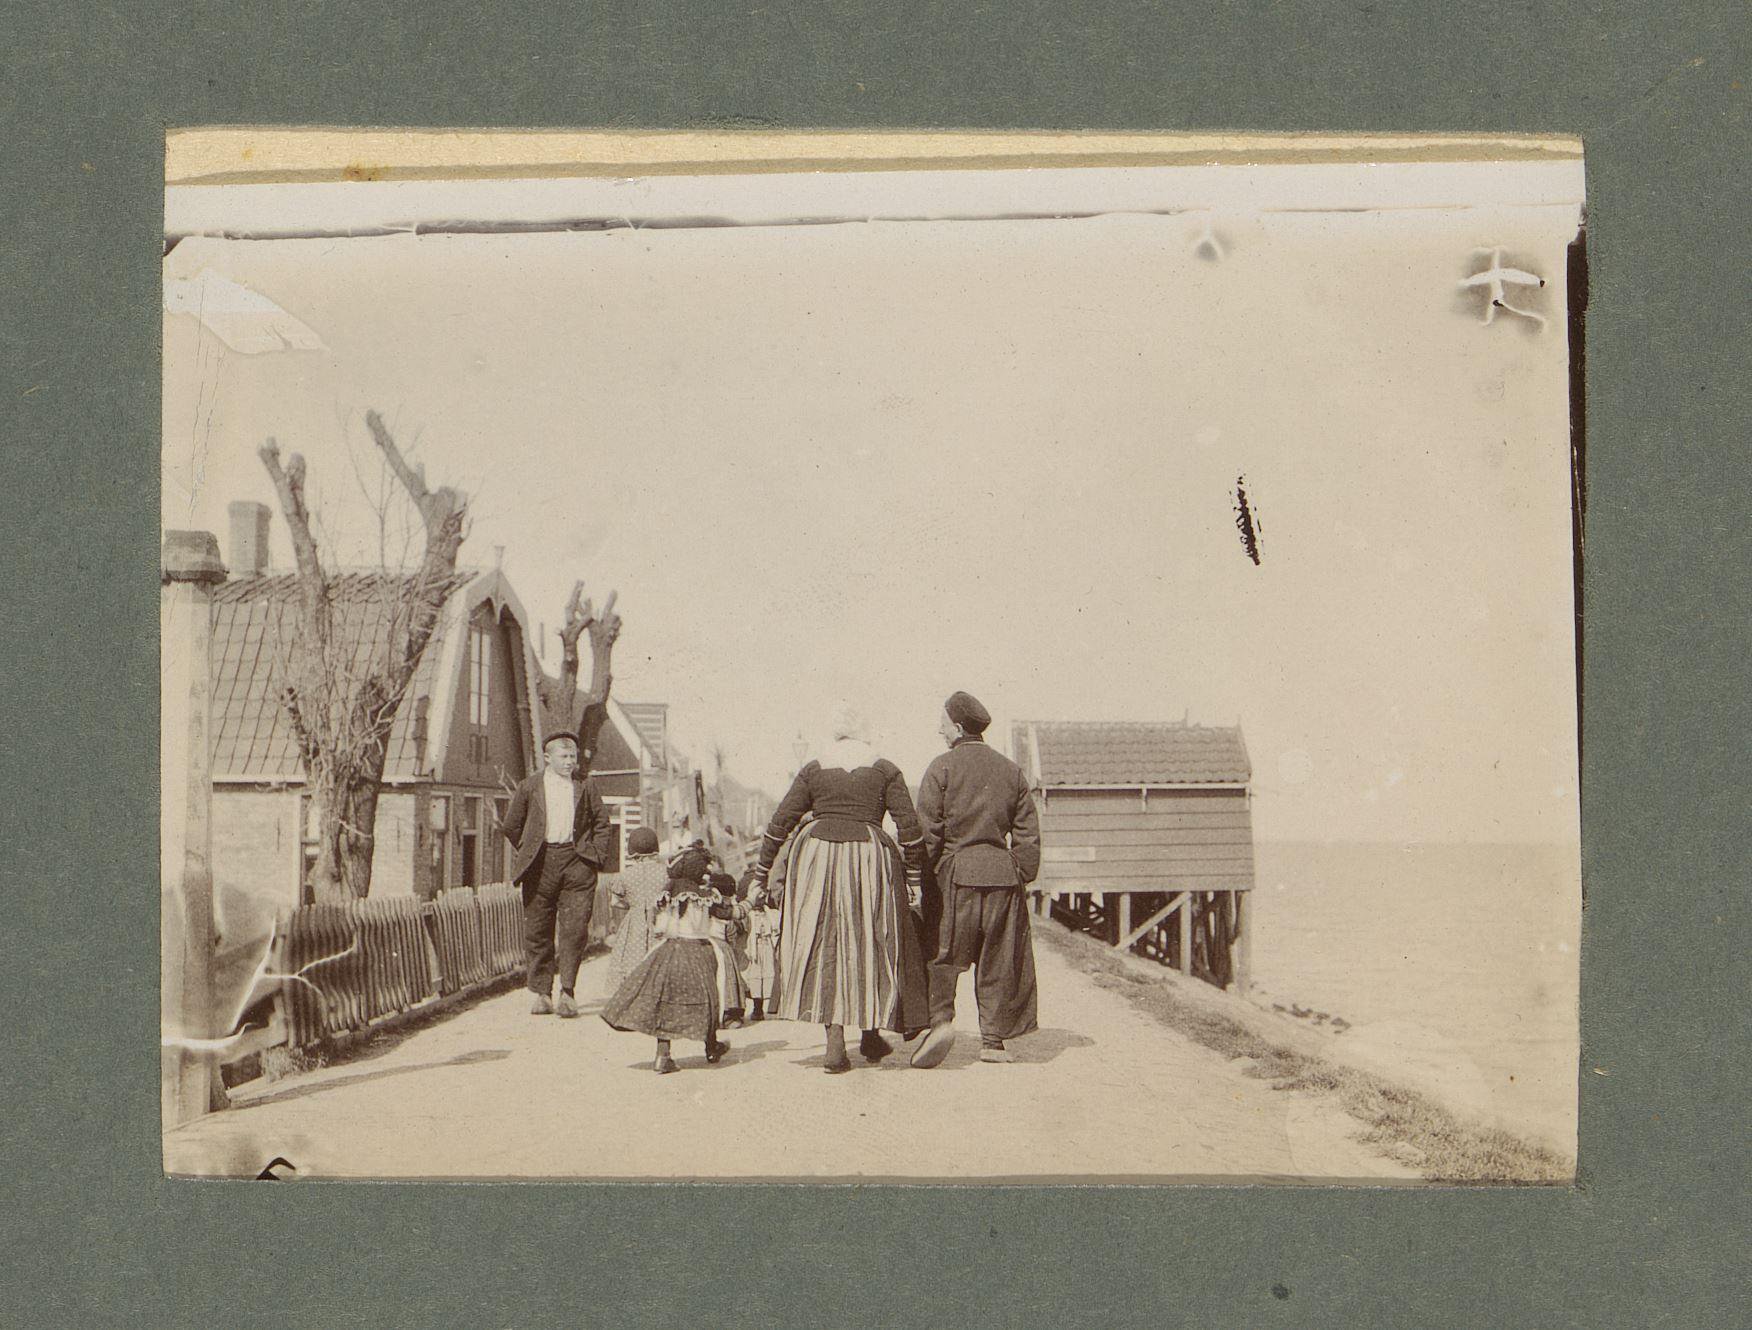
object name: album leaf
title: Gezin dat op straat wandelt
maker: george hidderley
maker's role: fotograaf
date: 1920-1940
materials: photographic support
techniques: gelatin silver print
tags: parents with their children, street